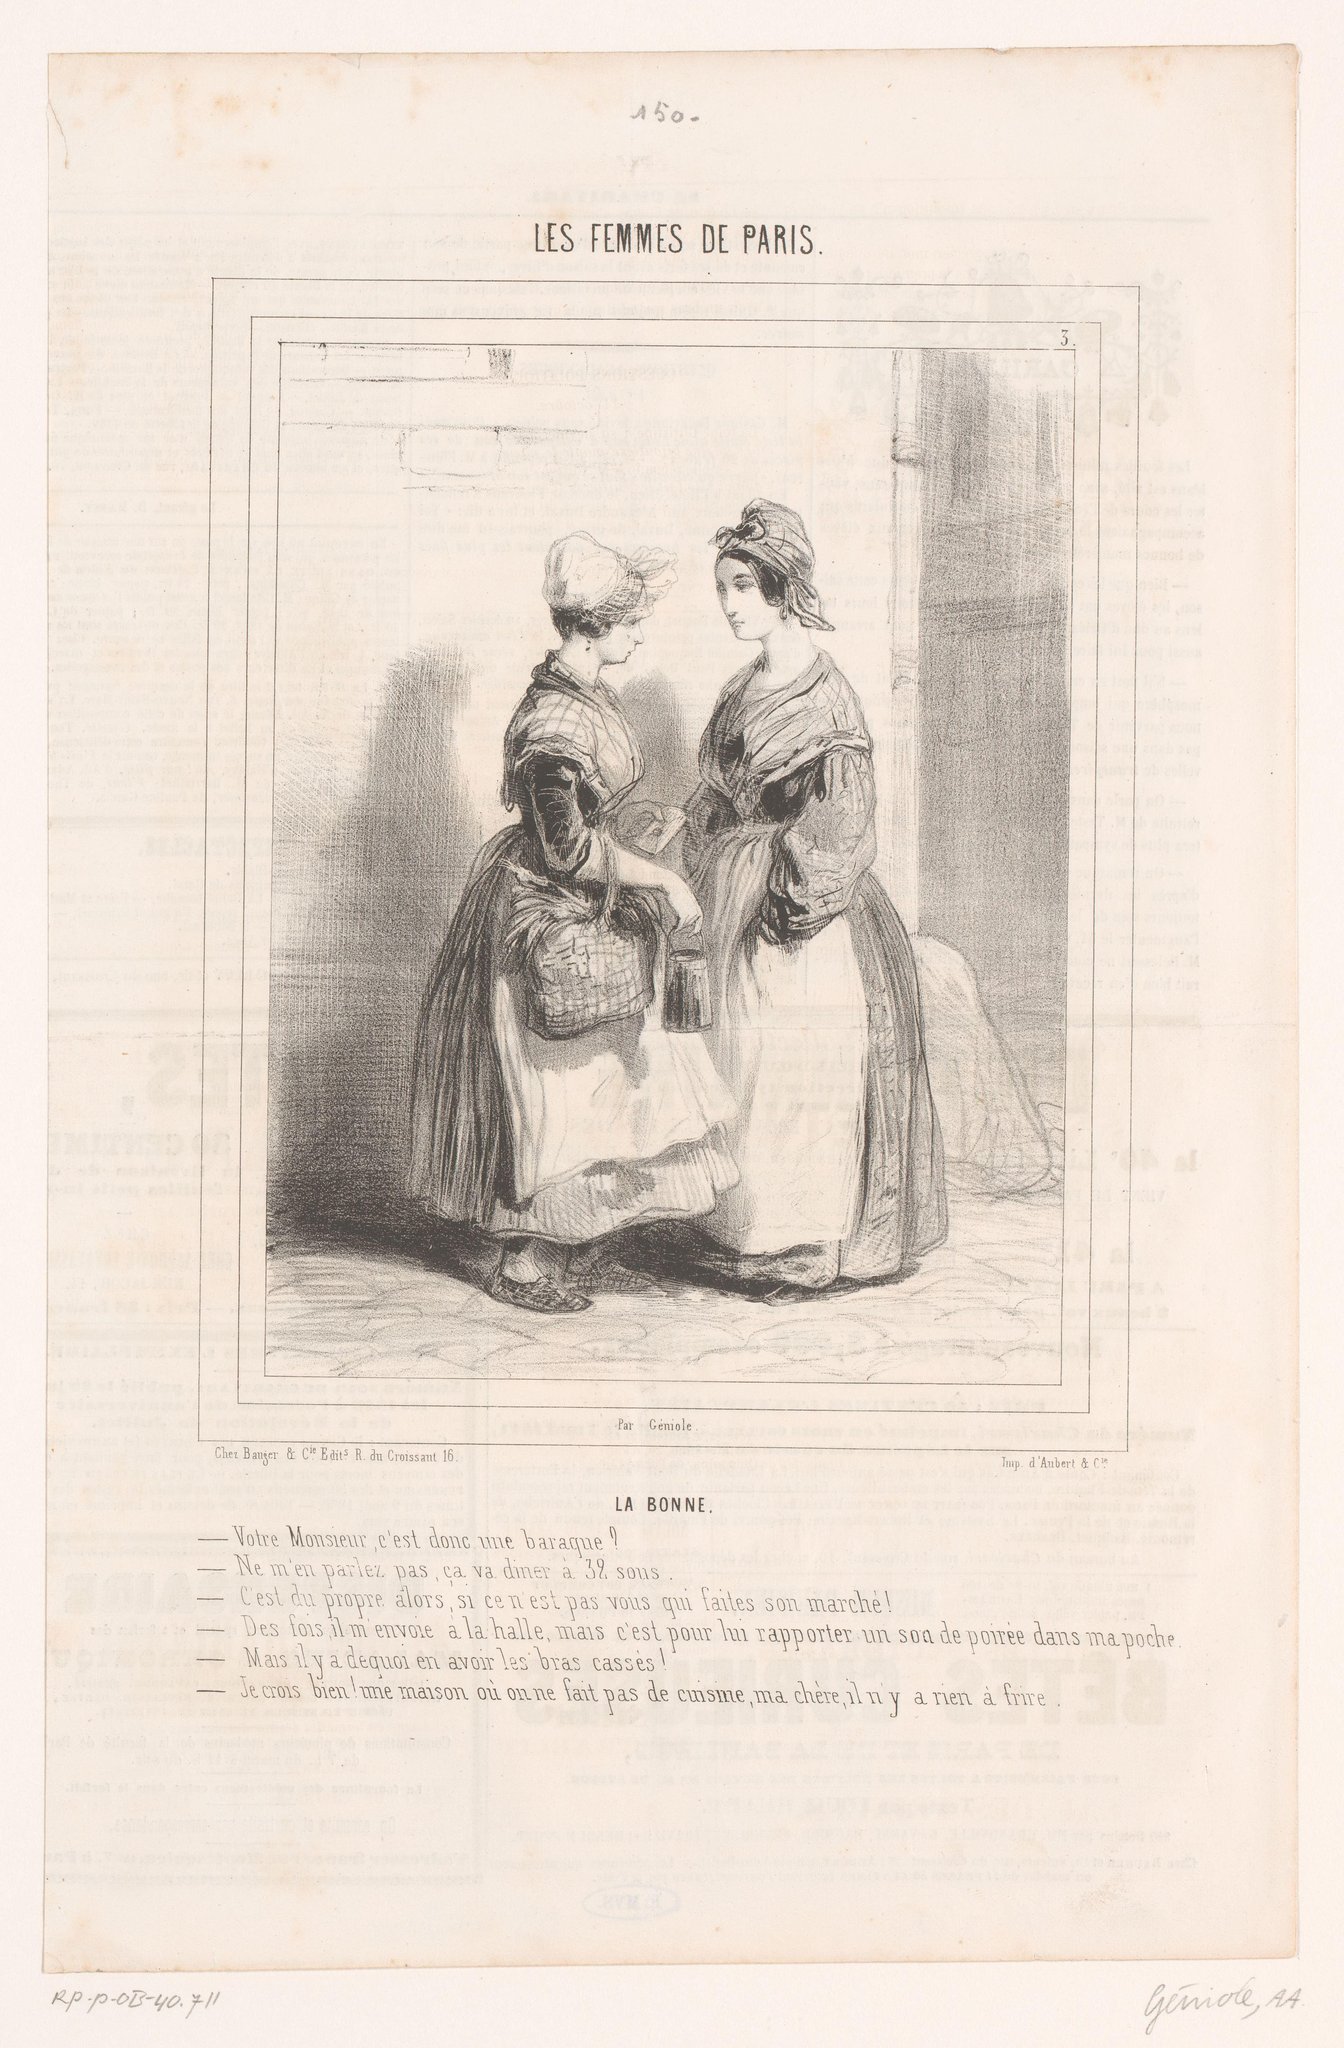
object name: print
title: La bonne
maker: alfred andré géniole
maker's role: print maker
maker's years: 1813-1861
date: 1842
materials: paper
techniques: lithograph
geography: paris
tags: maid ~ house personnel, conversation, dialogue; conversation piece, kitchen-maid, kitchen servant, street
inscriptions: collector's mark: Lugt 2228a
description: Prent gebruikt voor: Le Charivari, 1842.